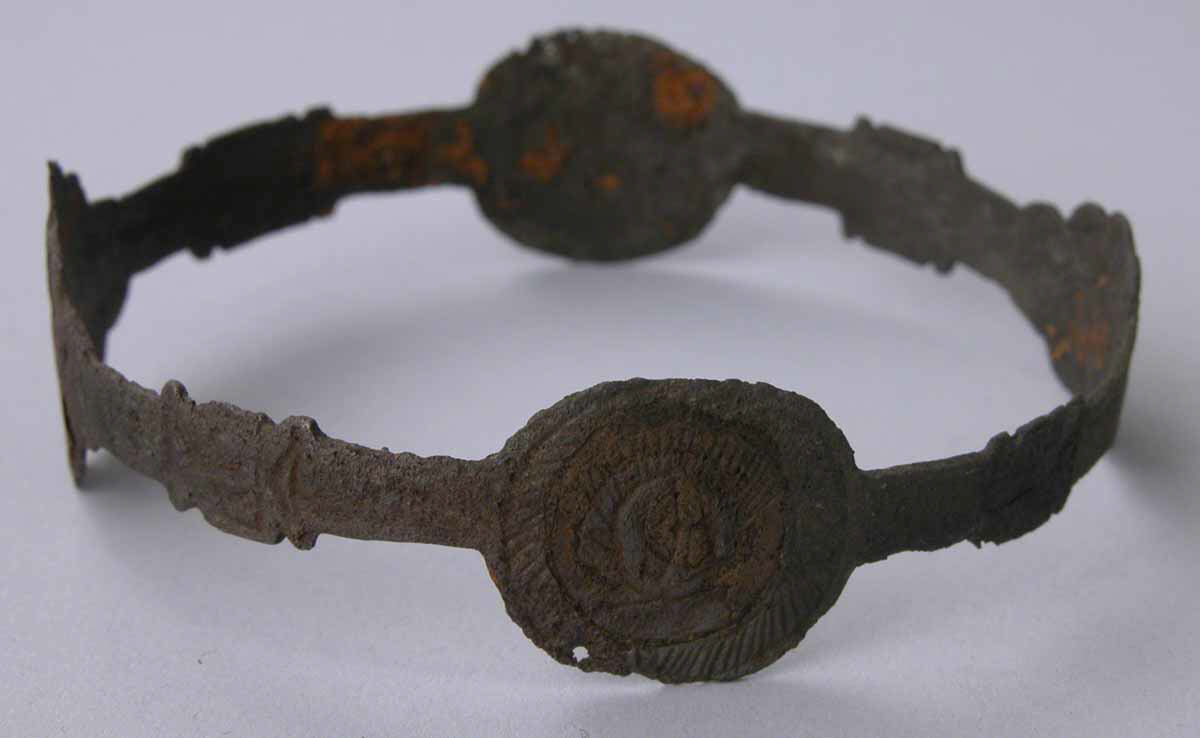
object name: bracelet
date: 501-800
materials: iron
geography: egypt